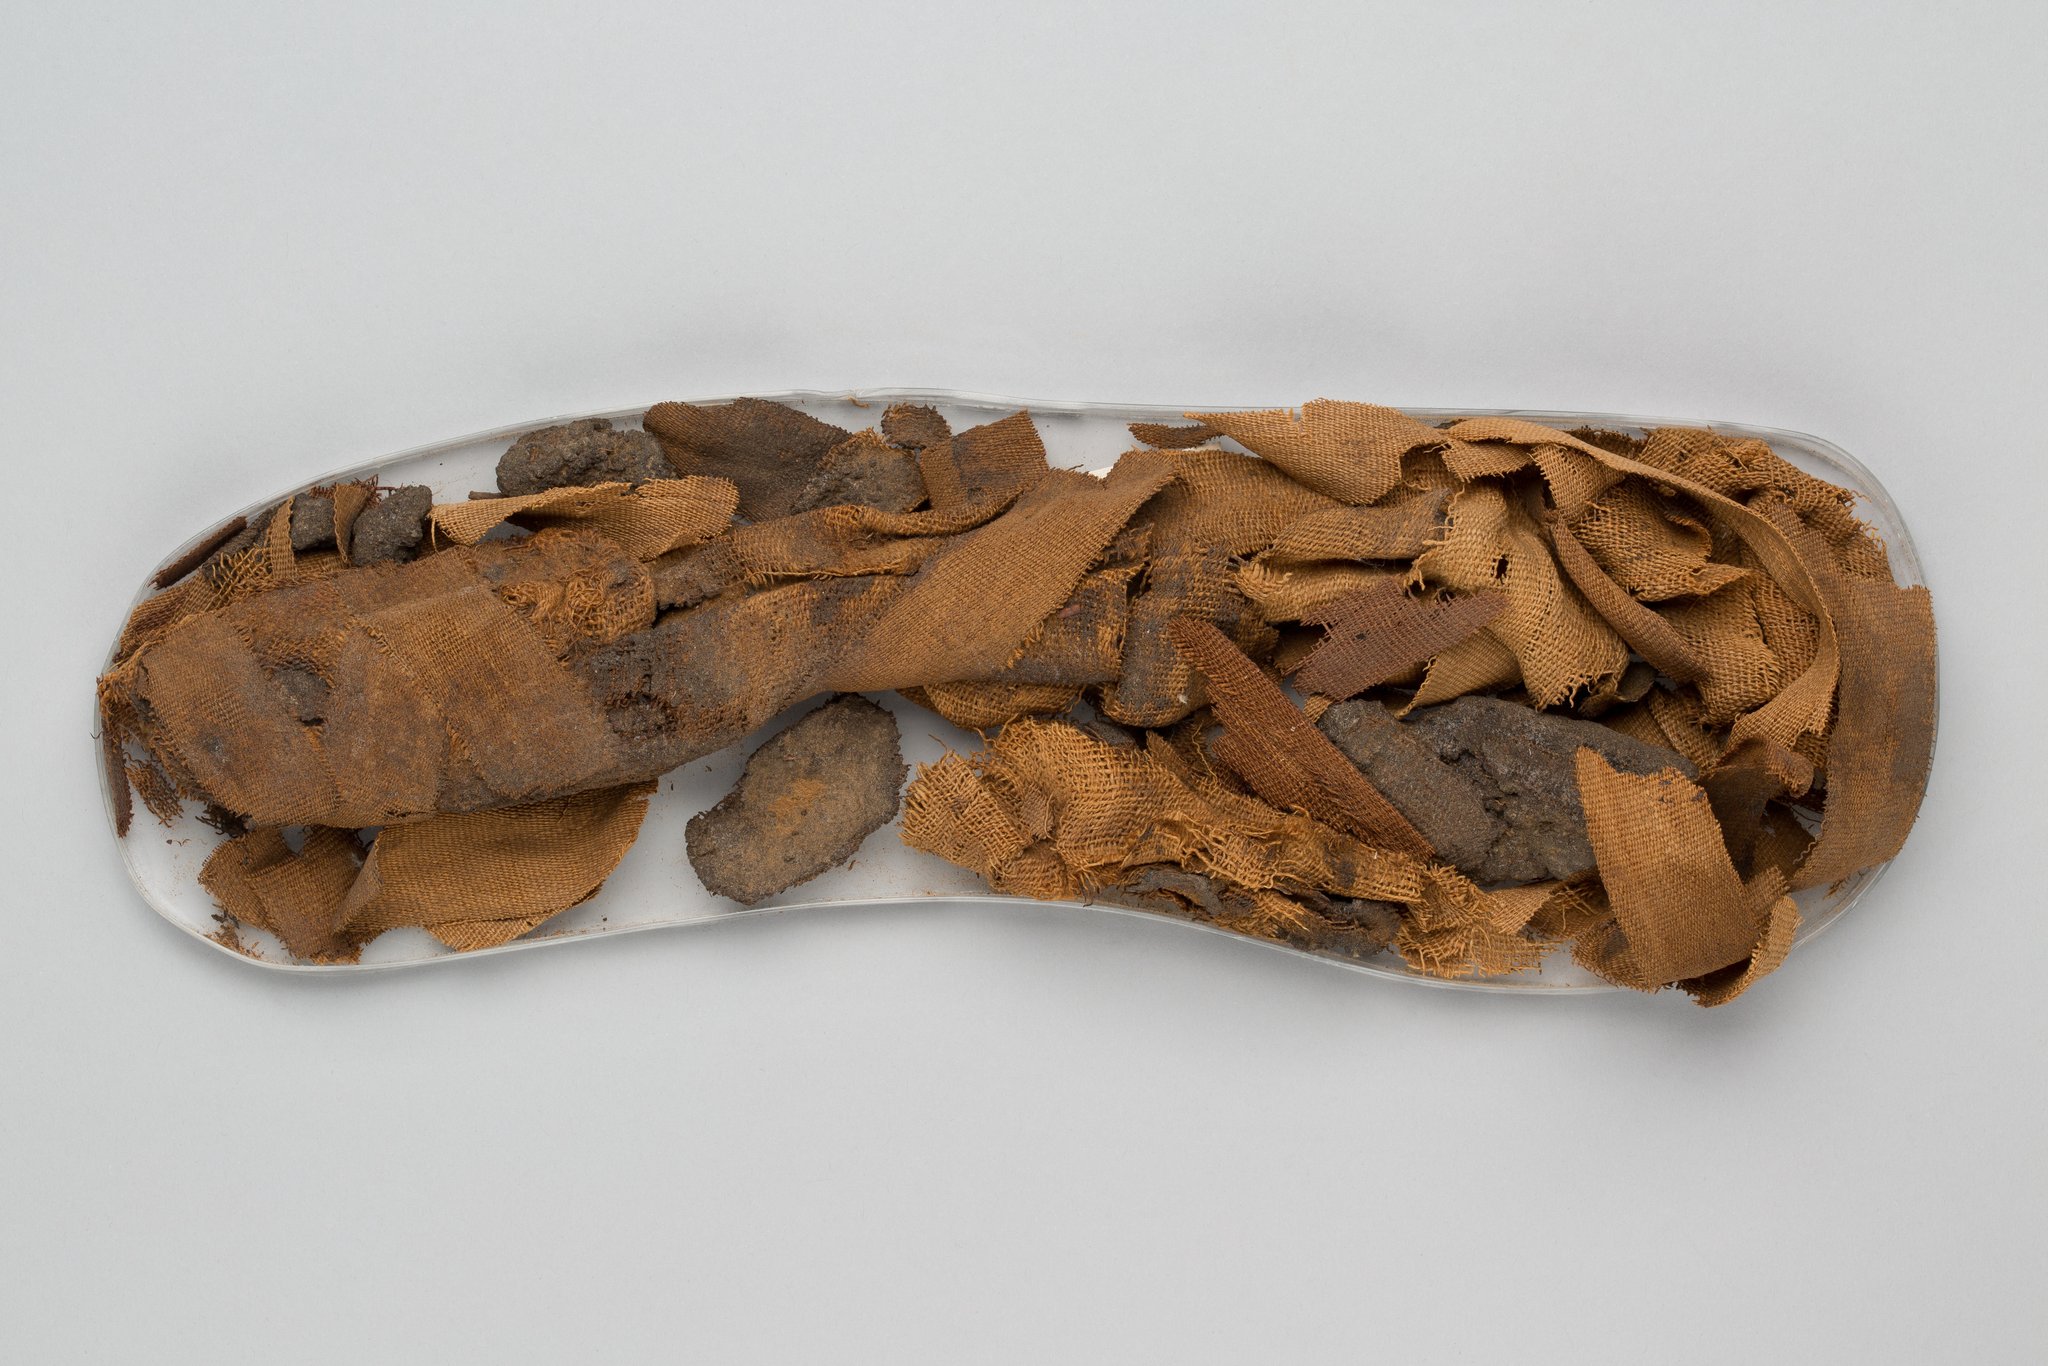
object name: linen, mud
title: Linen and mud from interior of Ptah-Sokar-Osiris figure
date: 306-30 BCE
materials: linen, mud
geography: egypt